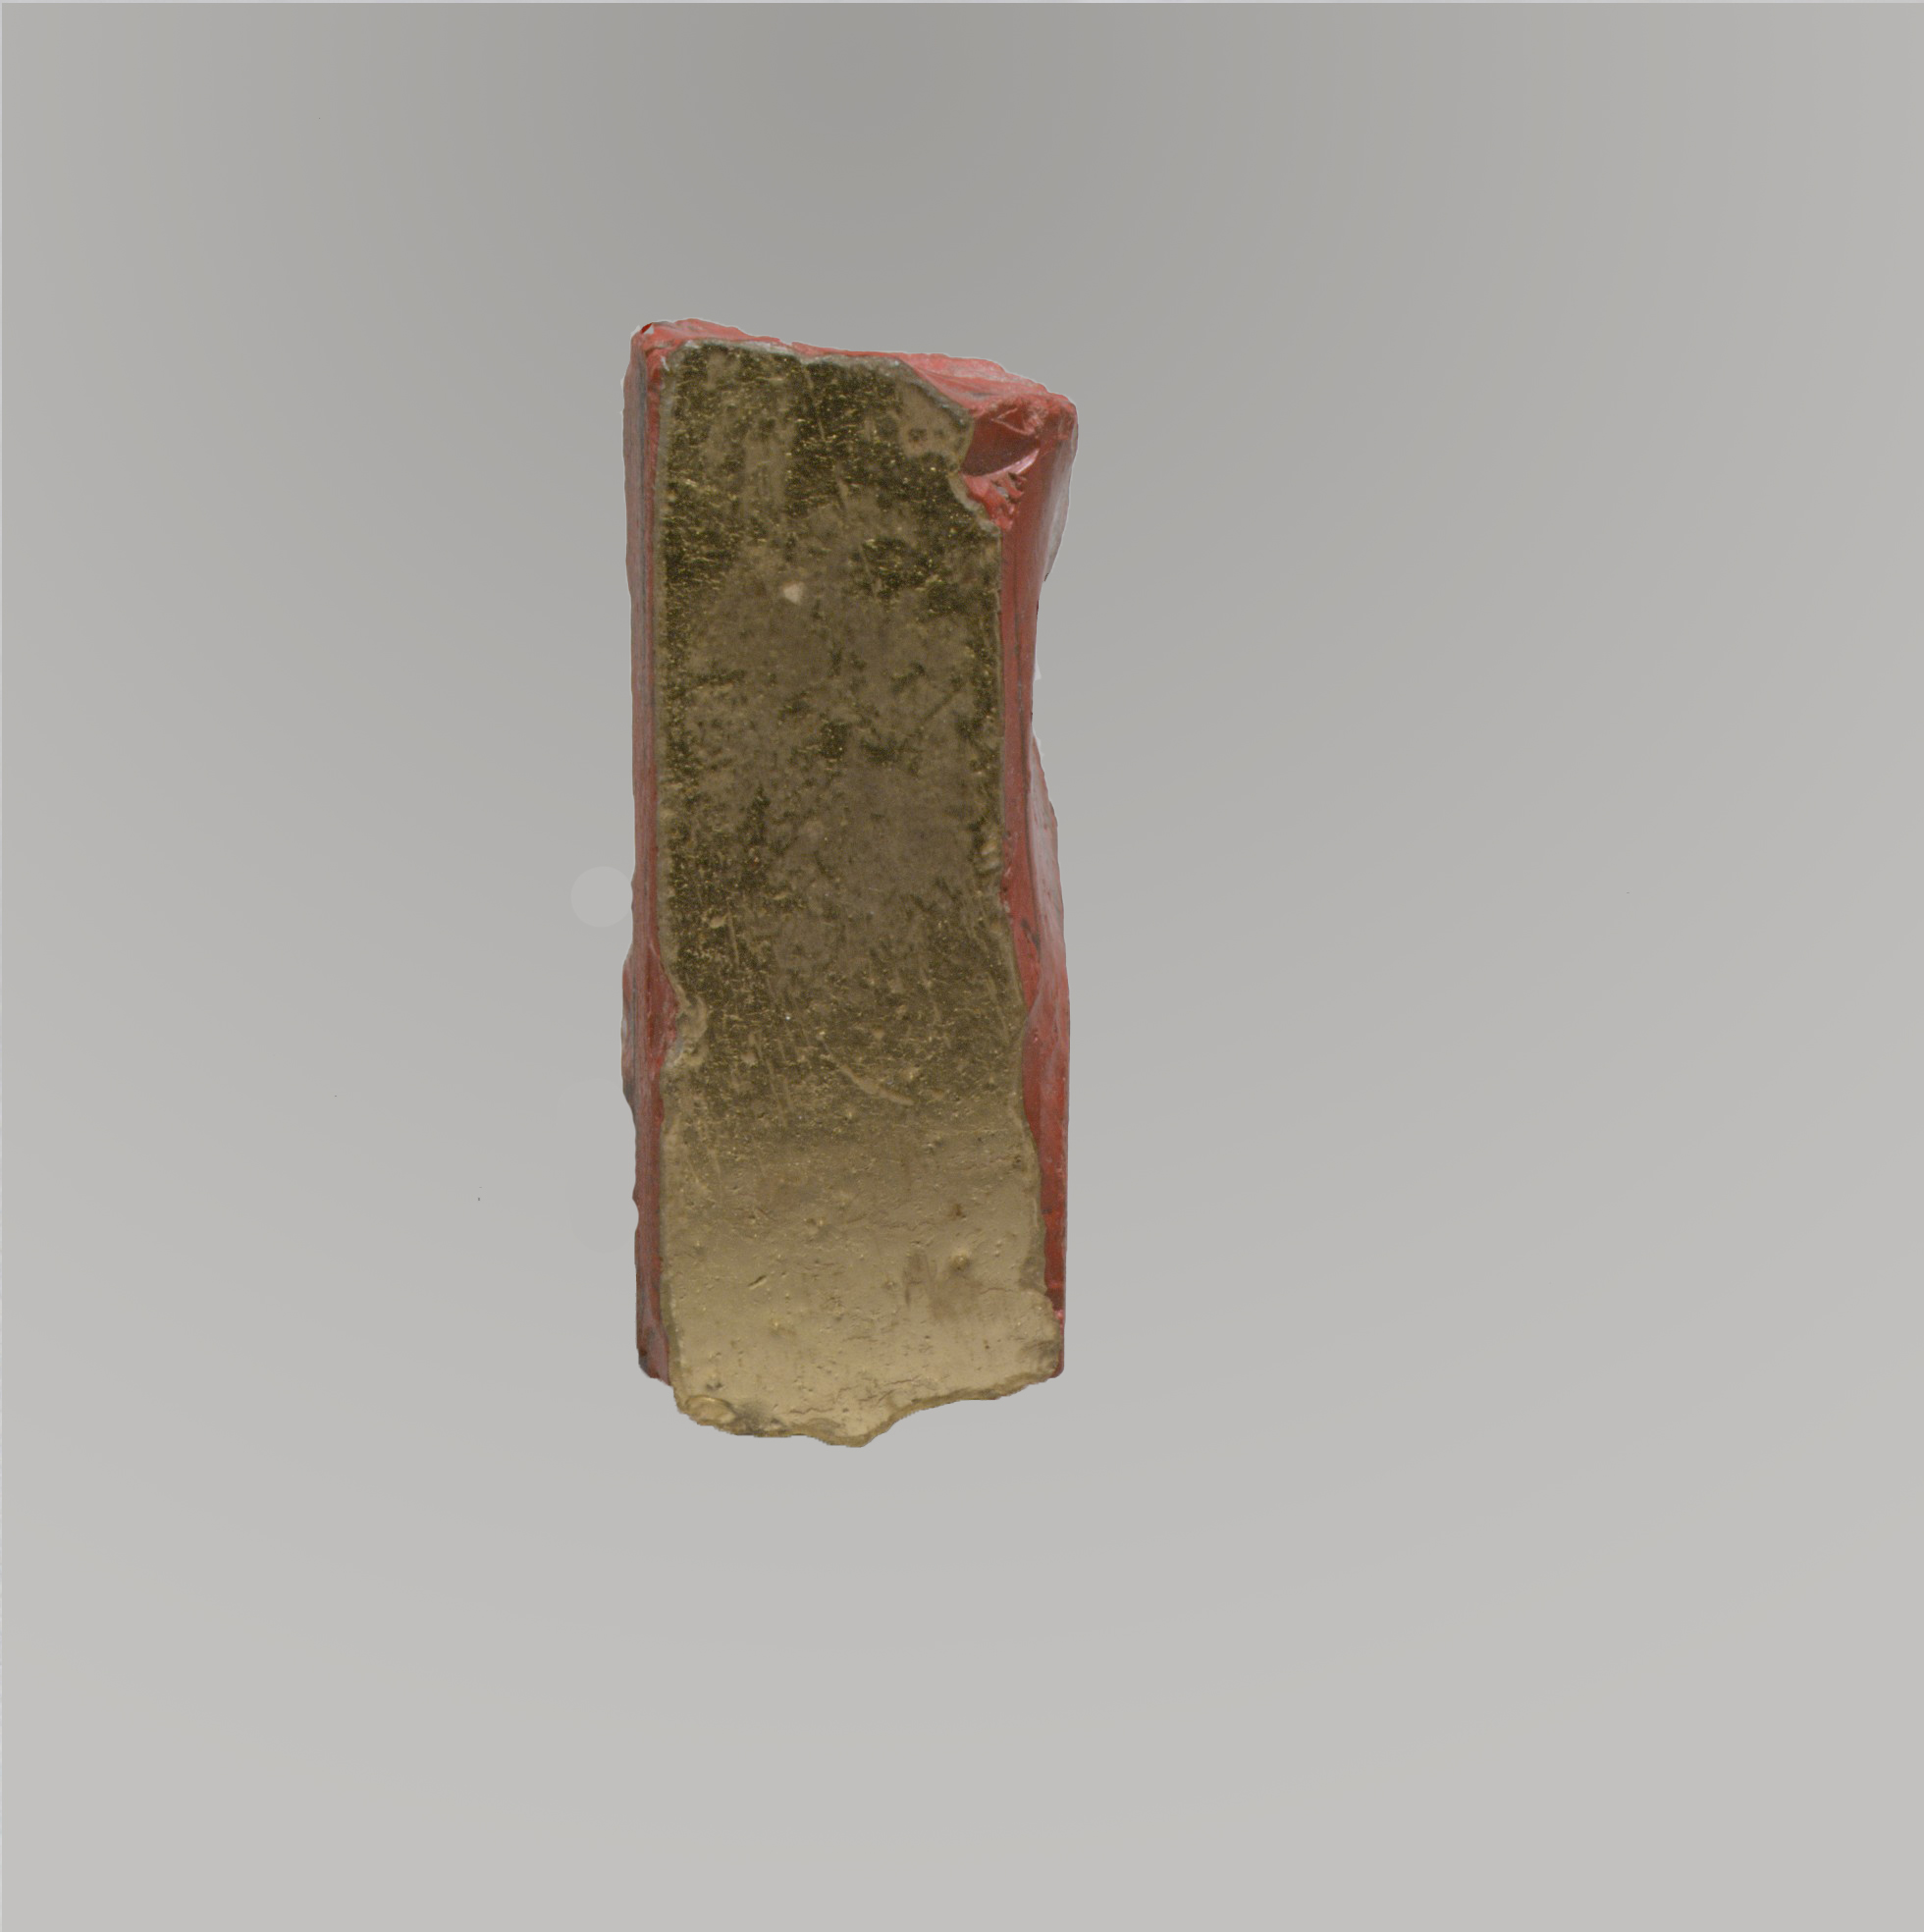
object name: block with gold leaf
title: Glass block with gold leaf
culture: roman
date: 34 BCE-33 CE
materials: glass